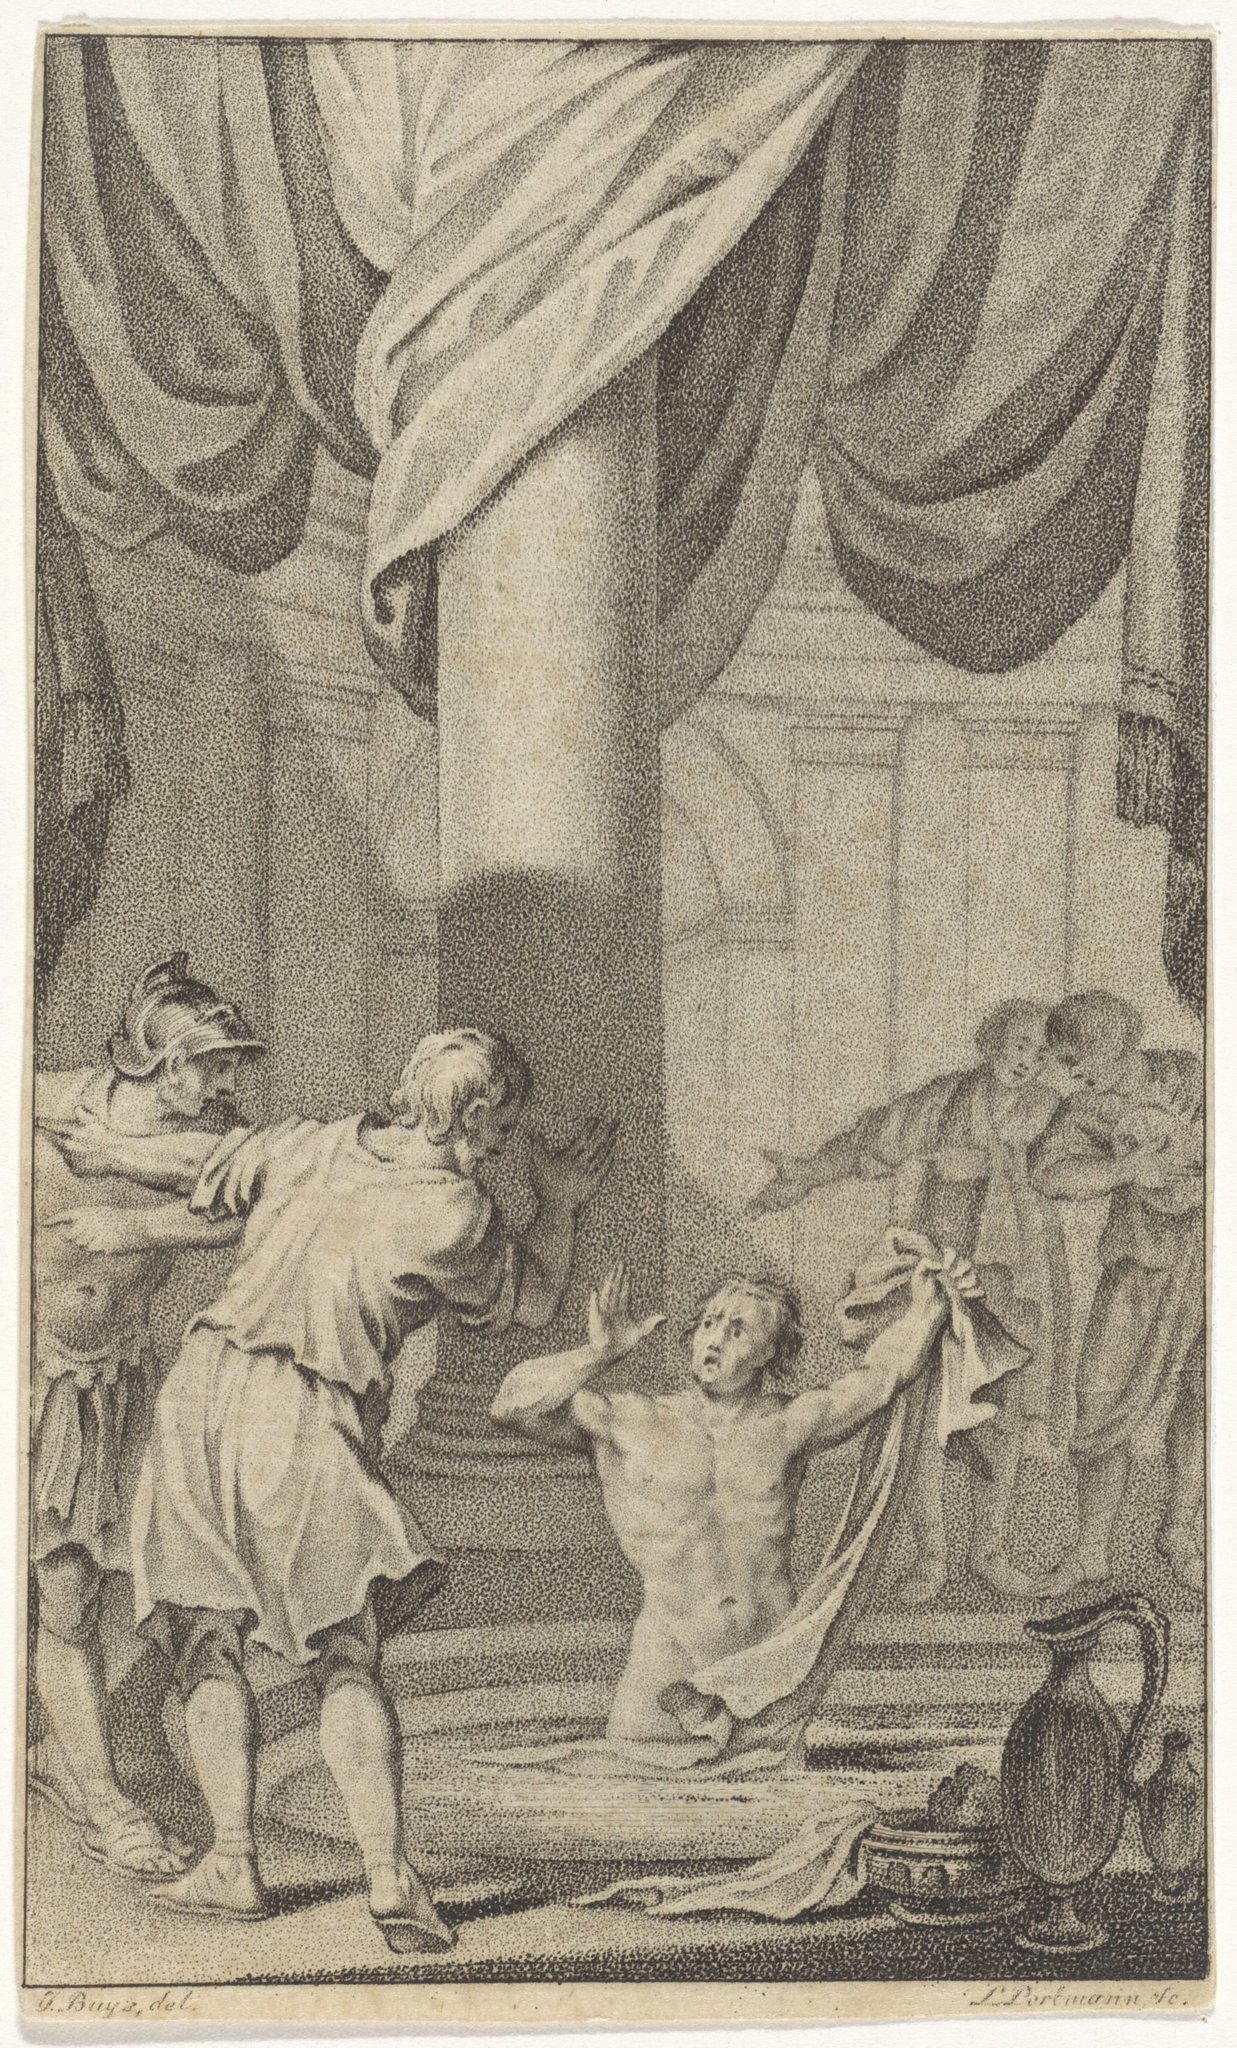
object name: book illustration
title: Overdreven angst van Perseus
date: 1797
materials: paper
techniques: stippled etching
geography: amsterdam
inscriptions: collector's mark: Lugt 2228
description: Perseus zit in de stad Dium in bad. Als hij te horen krijgt dat de vijand onderweg is naar de stad wordt hij onnodig bang. Hij geeft zich zonder gevecht gewonnen en beveelt Hippias en Asclepiodotus alle nederzettingen in Macedonië te ontruimen.